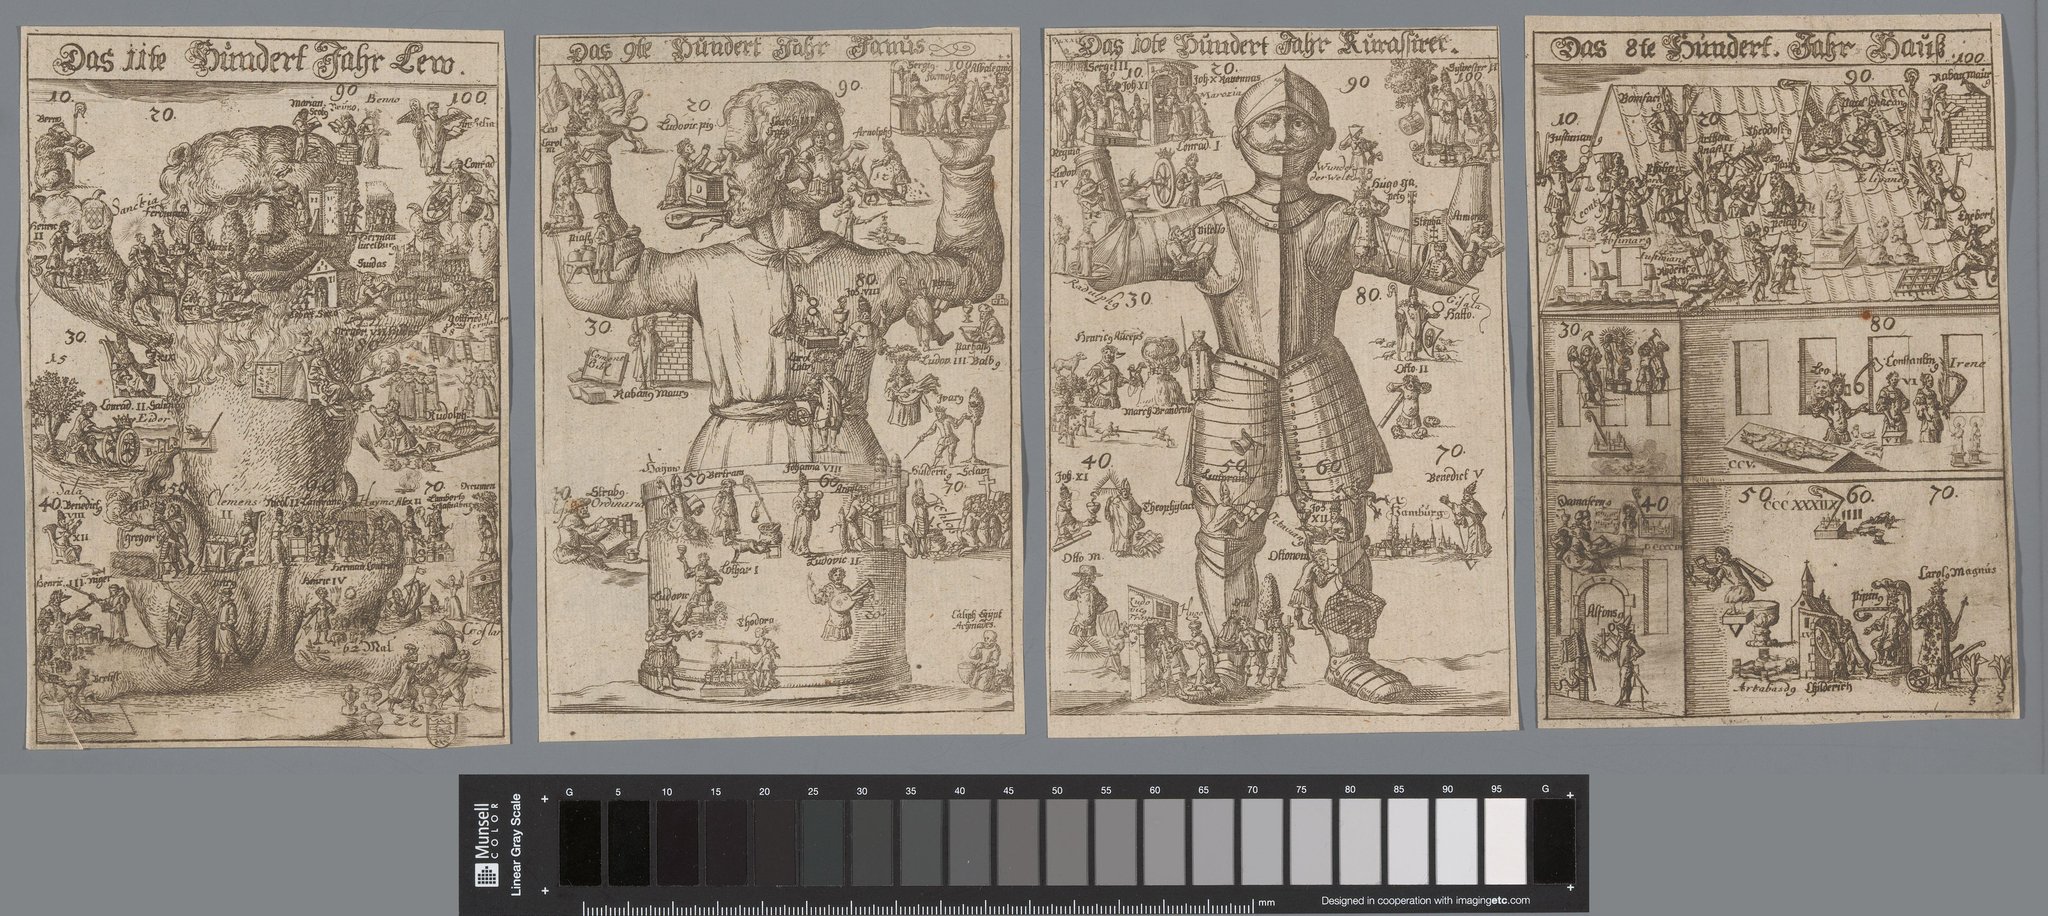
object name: print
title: Tiende eeuw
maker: Anonymous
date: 1667-1672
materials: paper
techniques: engraving, etching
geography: germany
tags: armour, knight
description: Prenten afkomstig uit een editie van: Johannes Buno, Historische Bilder/ Darinnen Idea Historiae Universalis : Eine kurtze Summarische Abbildung Der fürnehmsten Geist- und Weltlichen Geschichte durch die vier Monarchien ..., eerst uitgegeven door Bartold Elers in Lüneburg in 1672.